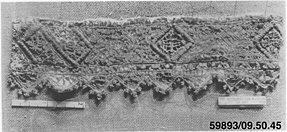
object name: strip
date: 1801-1900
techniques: lace